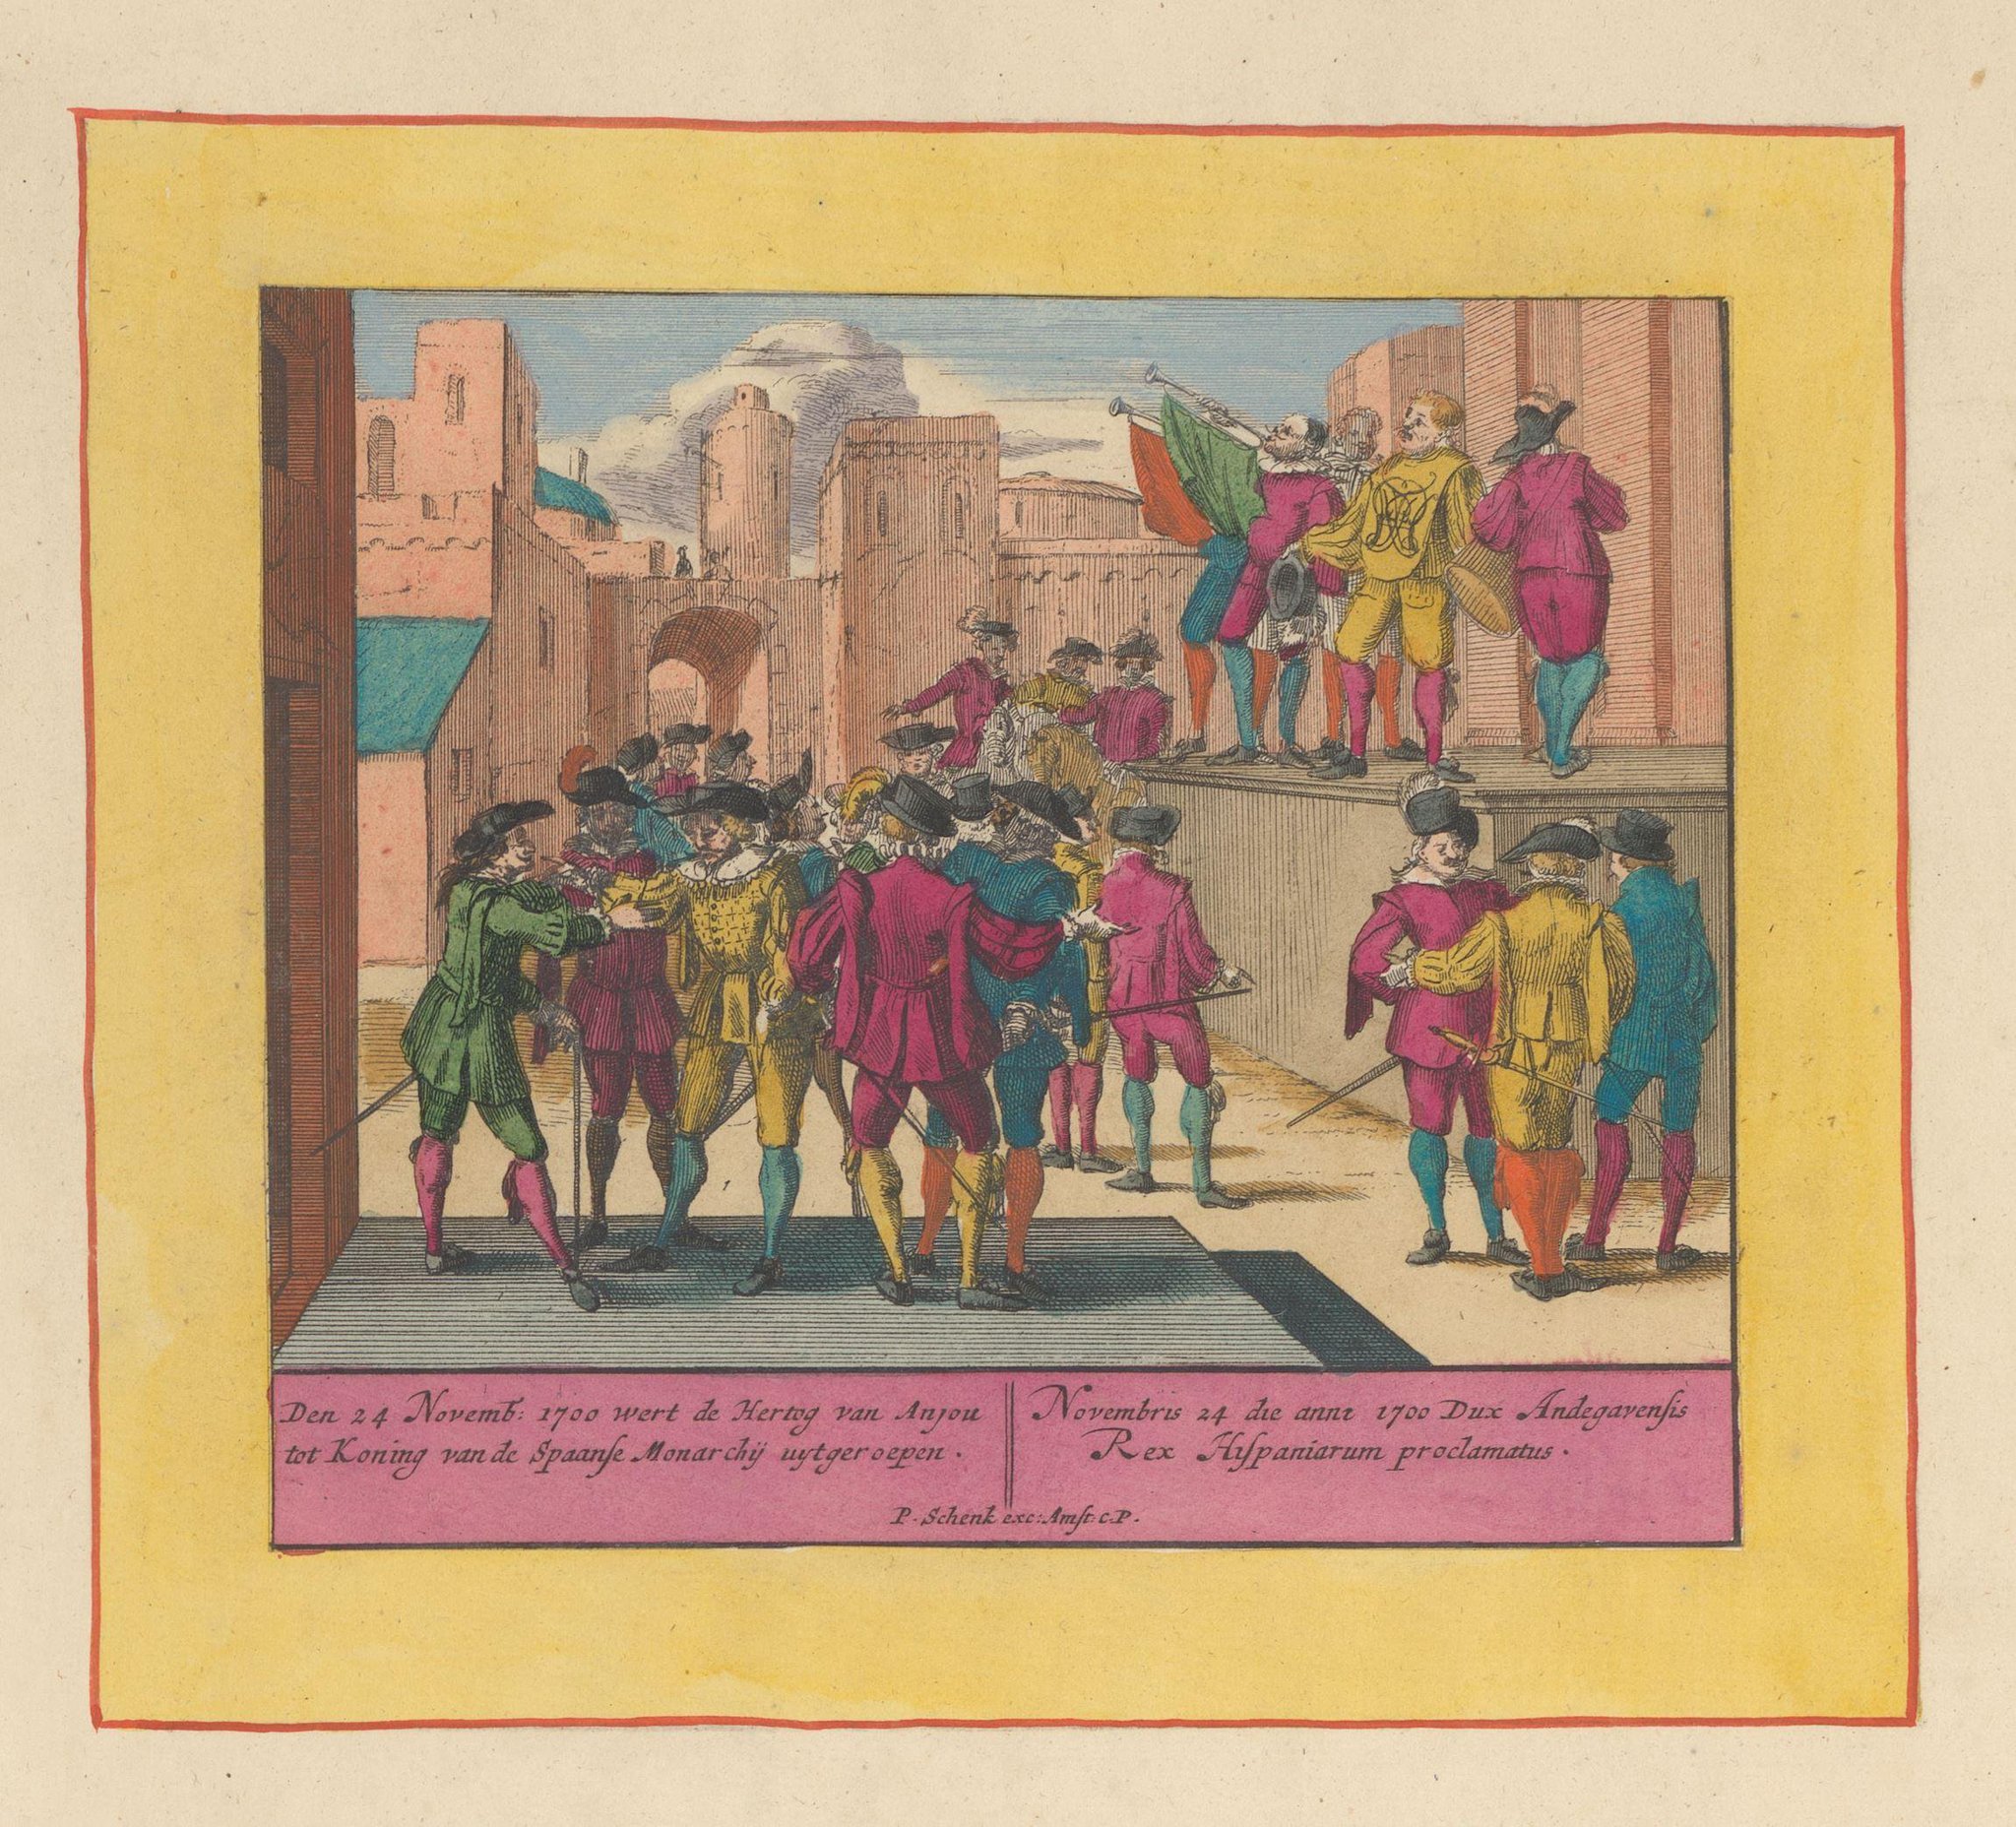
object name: album leaf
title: Filips van Anjou tot koning uitgeroepen, 1700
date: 1706-1720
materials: paper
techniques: etching, hand coloring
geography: amsterdam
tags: filips v (koning van spanje), installation of a ruler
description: Prent uit: Schouwburg van den oorlog, beginnende van Karel den II. tot op koning Karel den III. : bestaande in IX historische figuren op een olifants blad, als veldslagen, belegeringen te water en te lande, met de voornaamste vestingen. Amsterdam: Pieter Schenk, 1706.